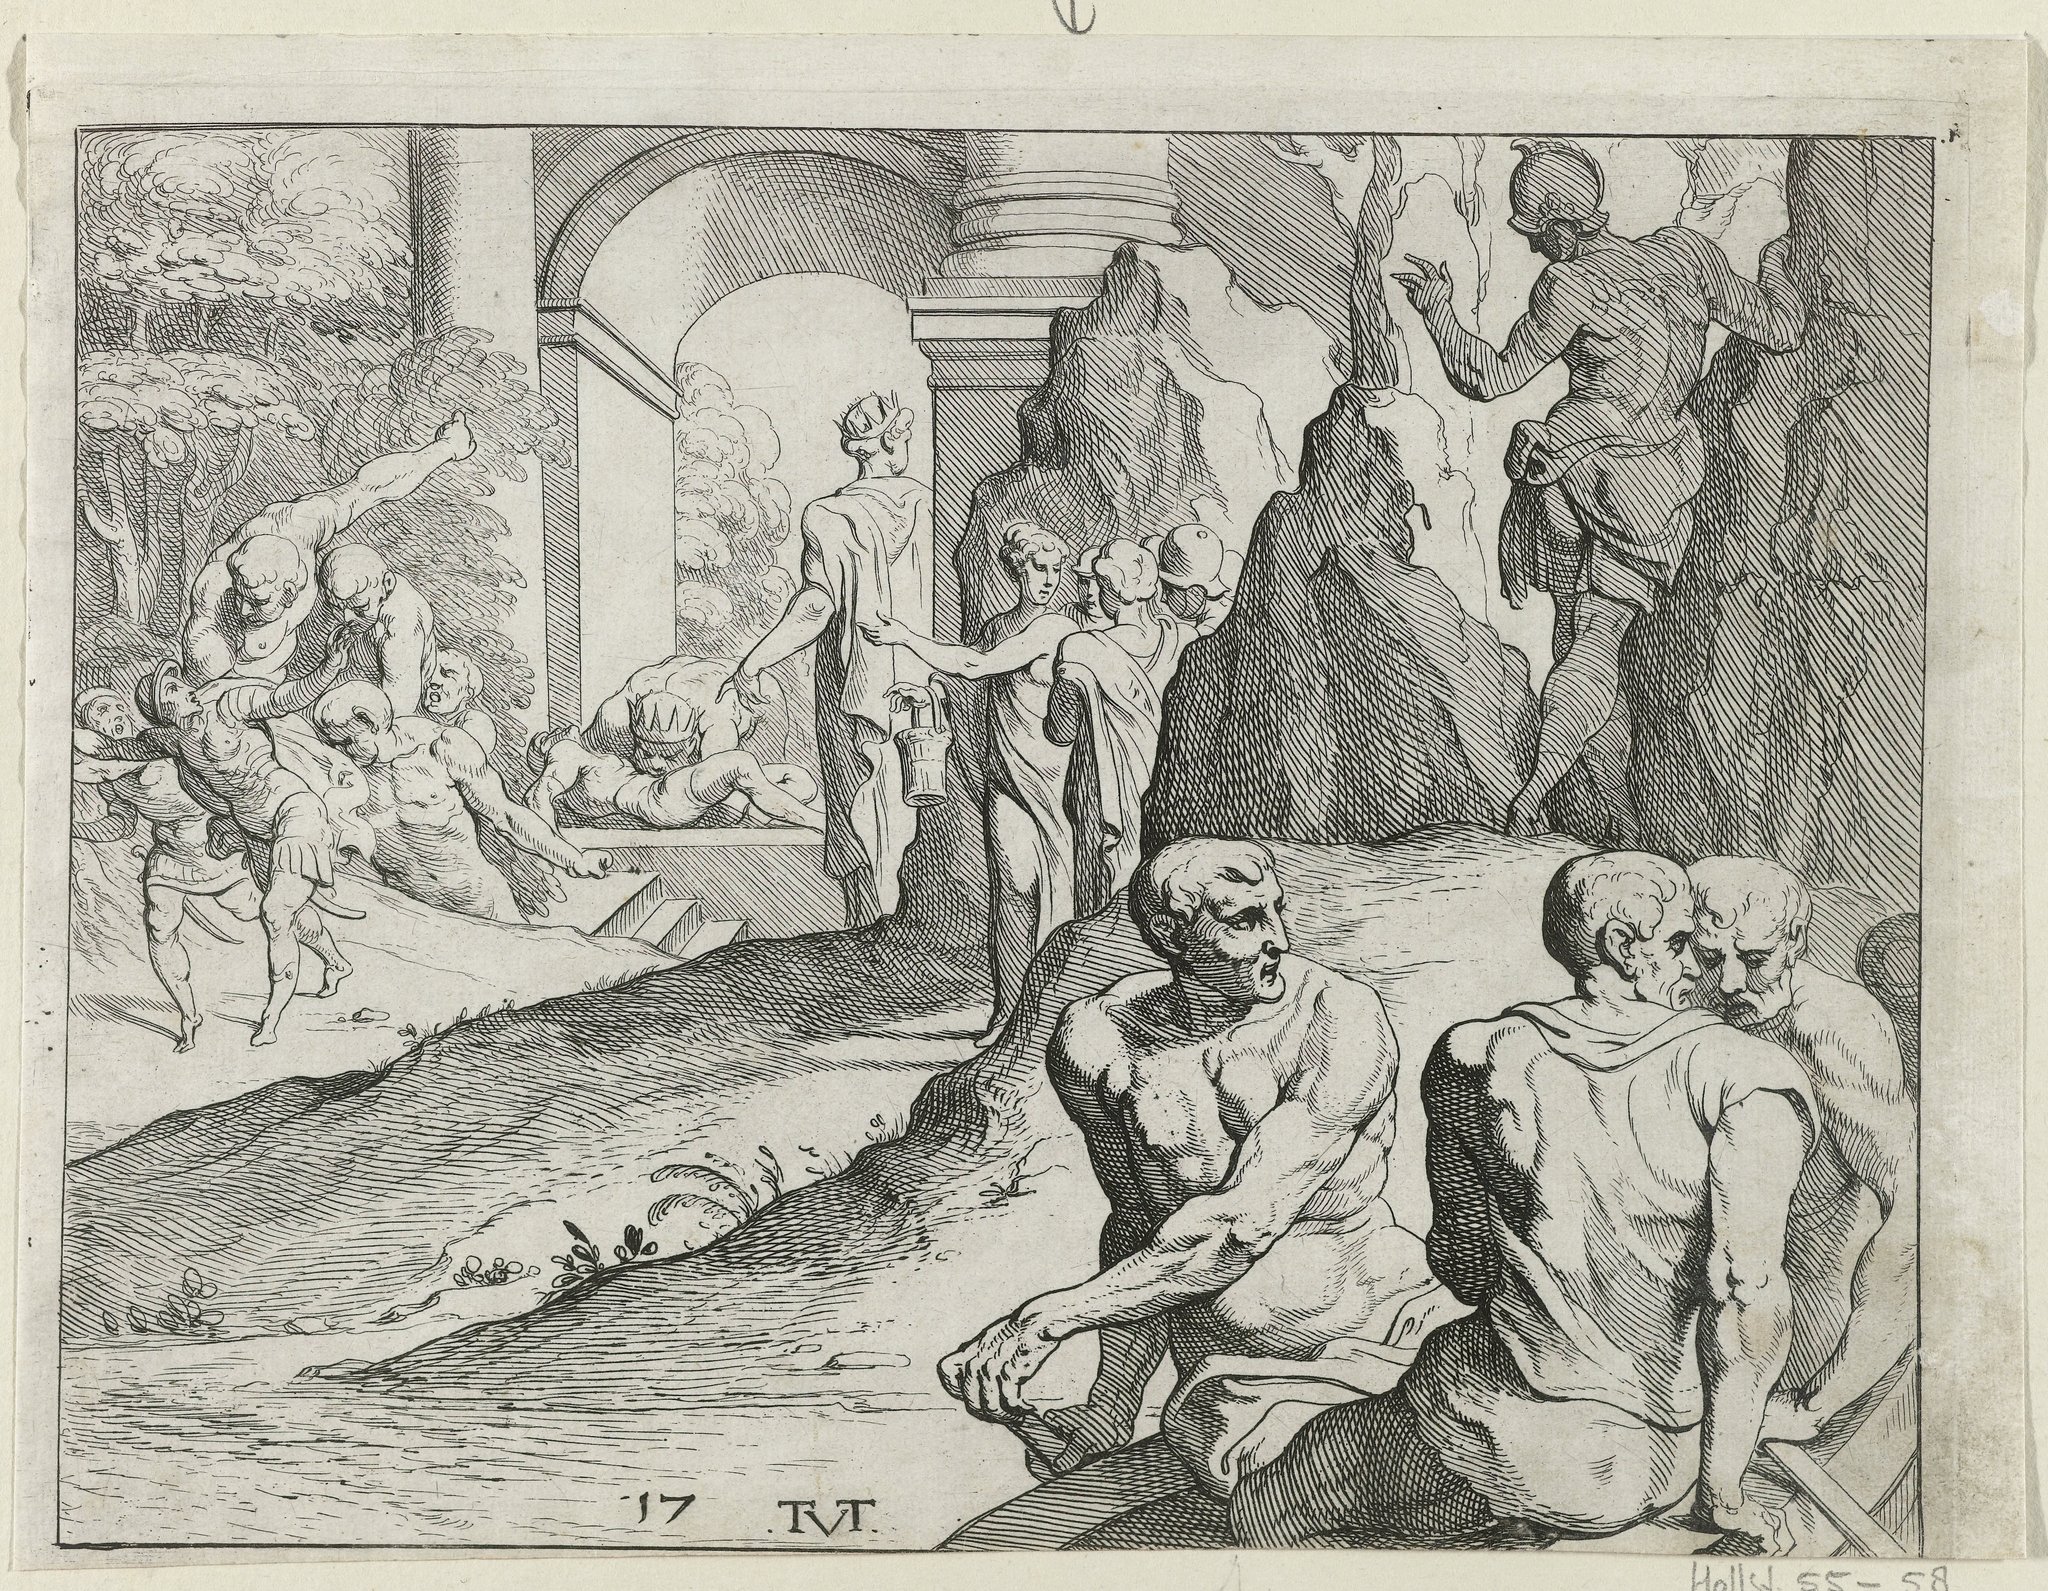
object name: print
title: De werken van Odysseus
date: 1632-1633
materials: paper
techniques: engraving, etching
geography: paris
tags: ulysses comes to the land of the laestrygones, the cannibal giants, who devour some of ulysses' comrades and destroy their ships (homer, odyssey x)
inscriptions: collector's mark: Lugt 2228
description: In het land van de Laistrygonen wordt een aantal van Odysseus' mannen opgegeten door de reuzen die er wonen. Op de voorgrond varen drie mannen weg van het eiland.